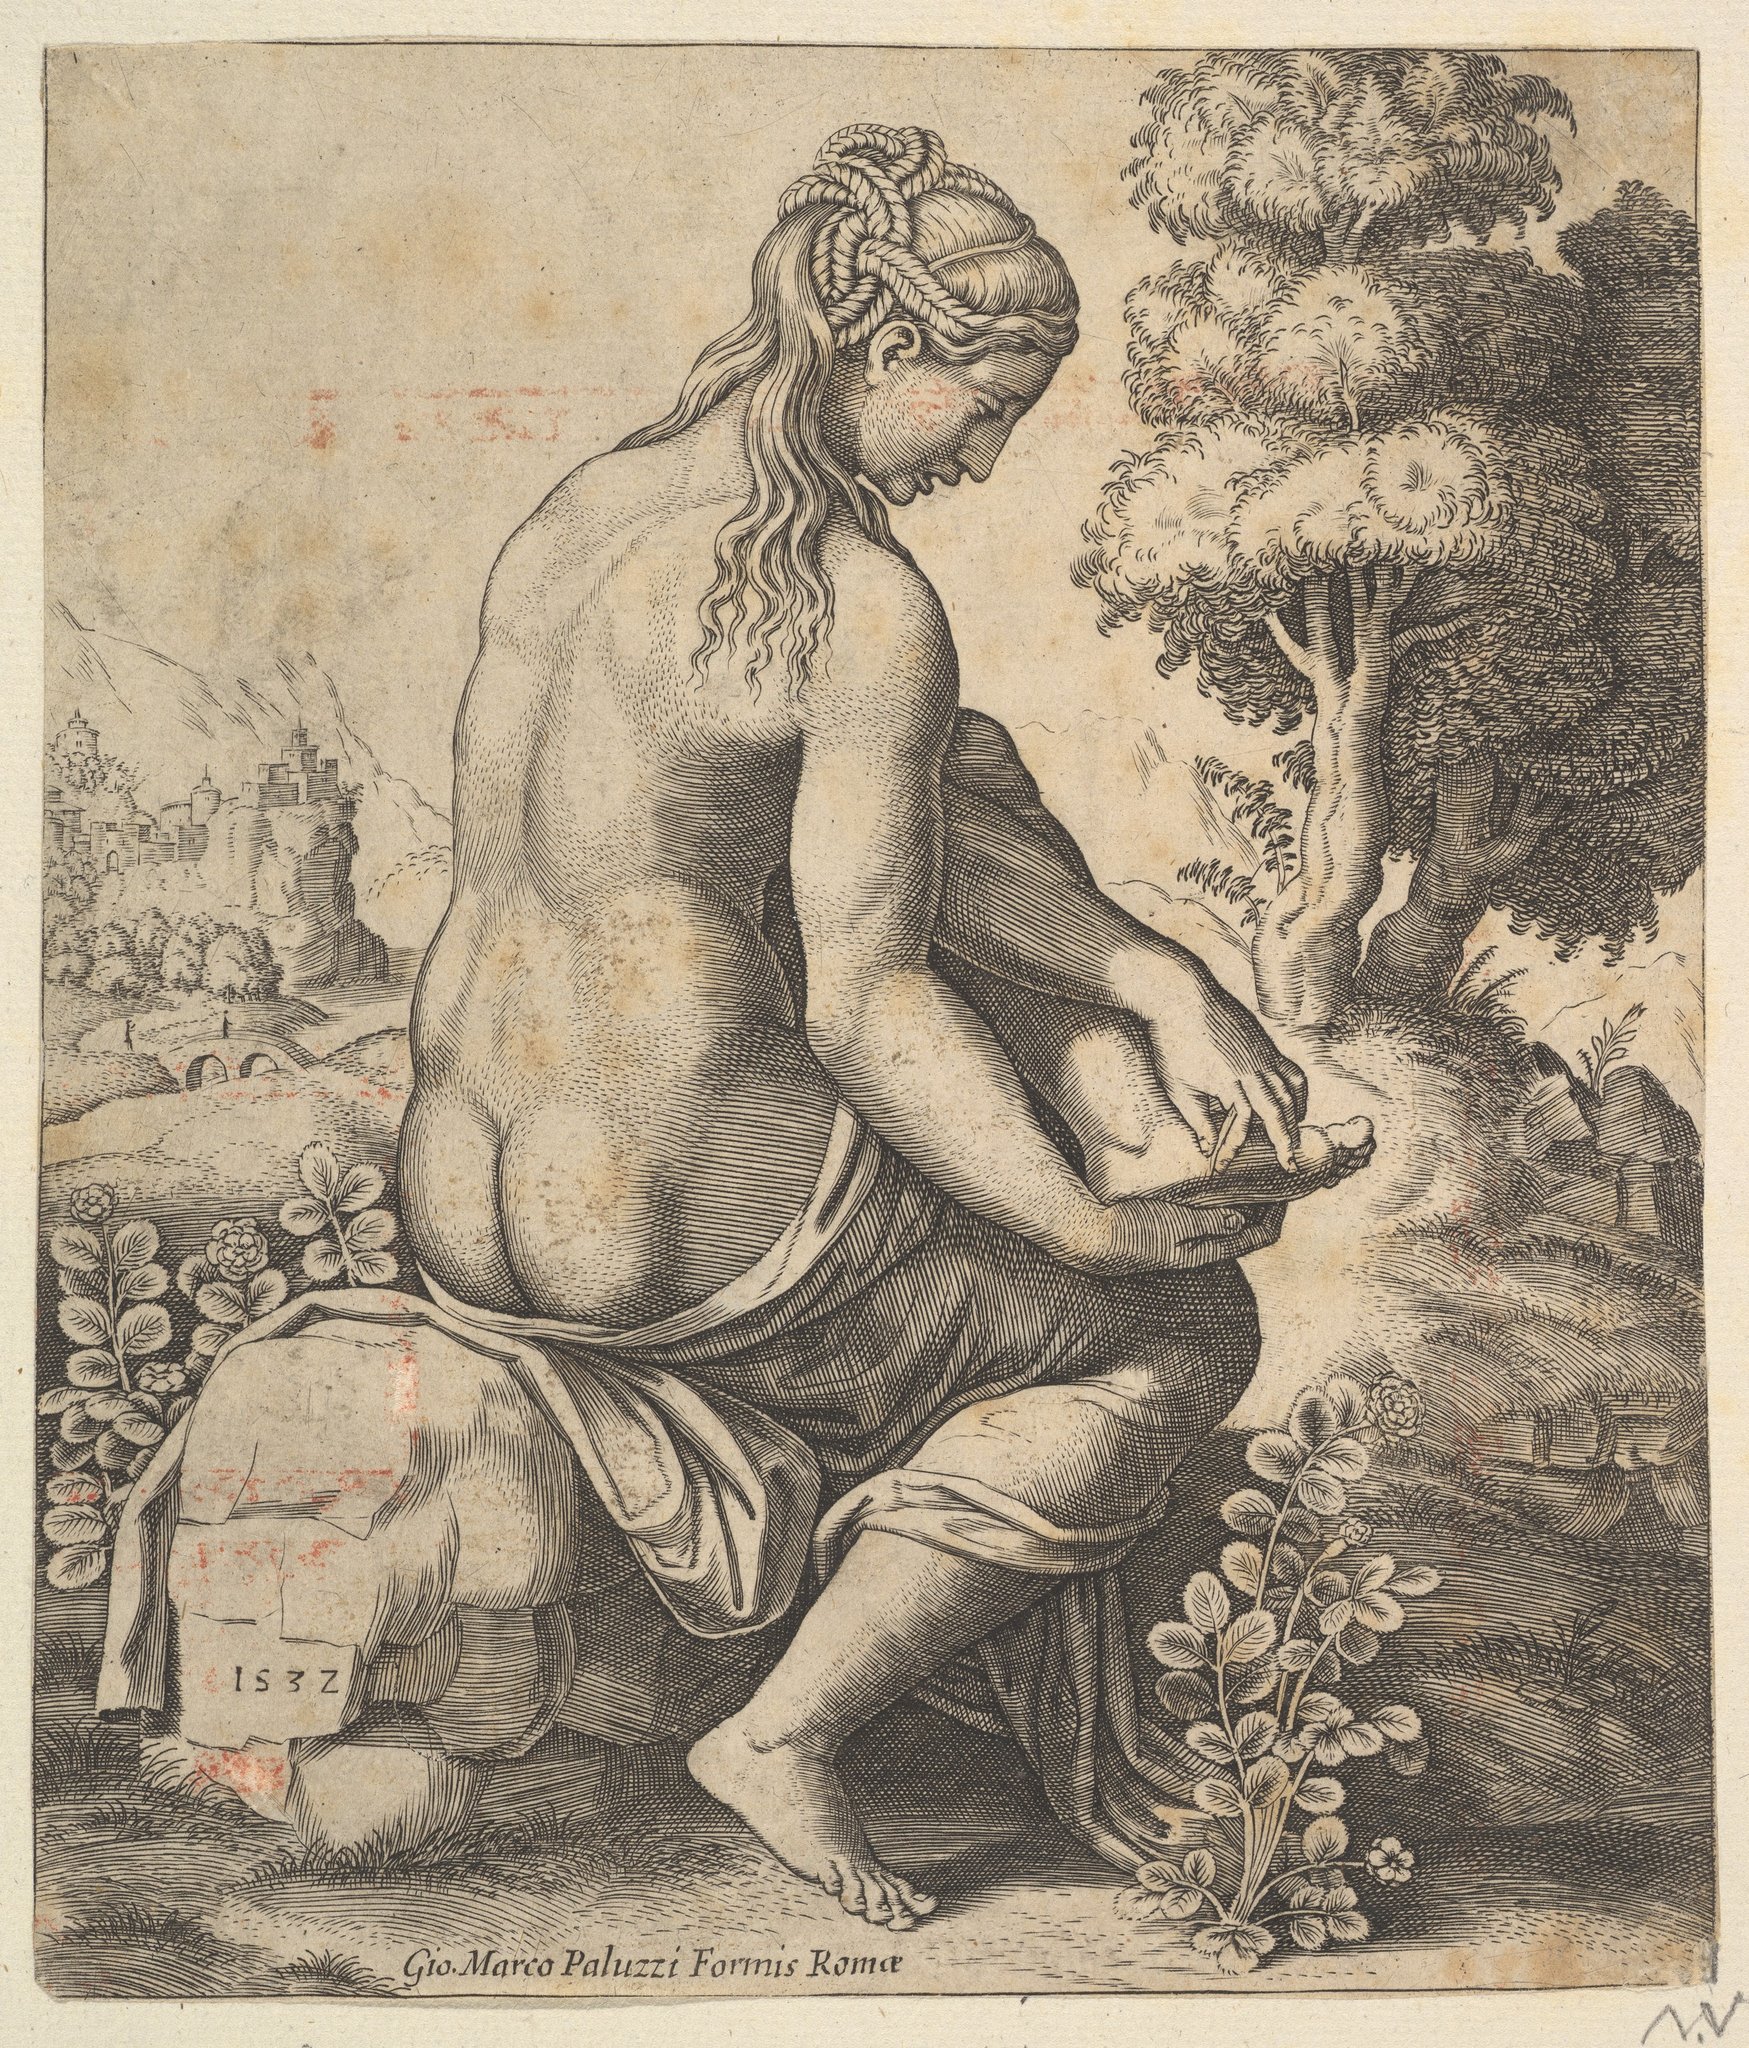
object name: print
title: Venus removing a thorn from her foot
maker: master of the die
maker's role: artist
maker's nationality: italian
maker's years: 1525-1560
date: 1532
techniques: engraving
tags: venus